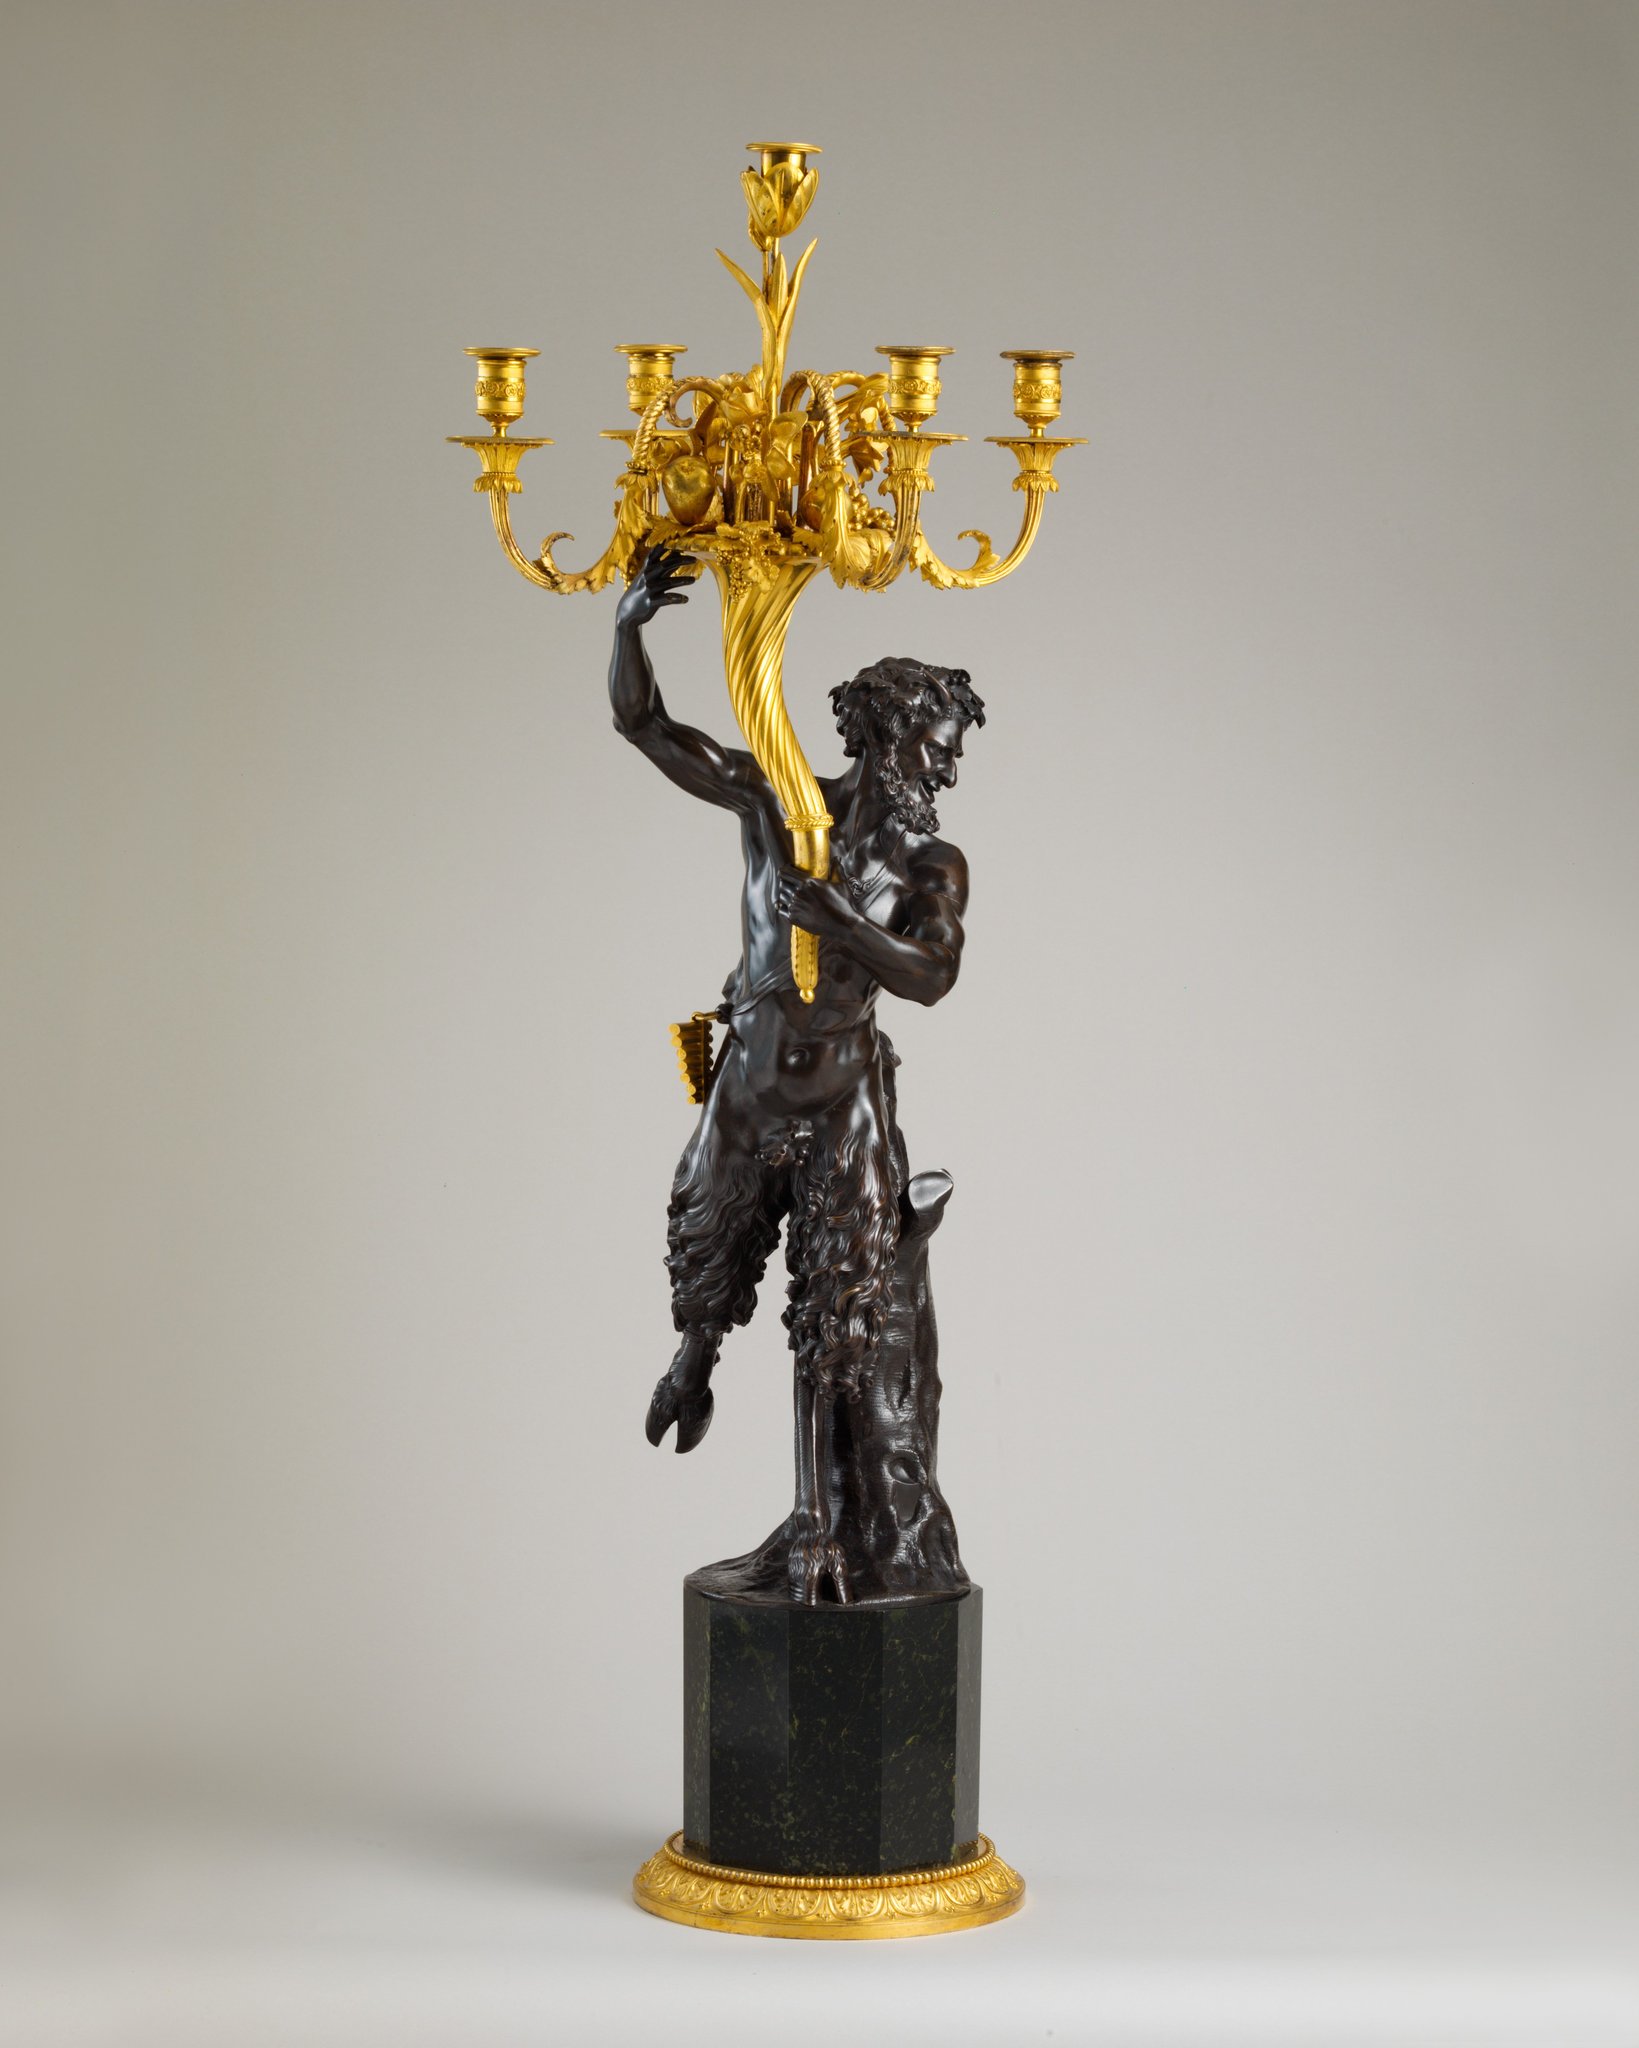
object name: candelabrum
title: Five-light candelabrum (one of a pair)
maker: clodion (claude michel)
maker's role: modeler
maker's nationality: french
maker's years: 1738-1814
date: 1785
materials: bronze, gilt, marble, stone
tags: satyrs